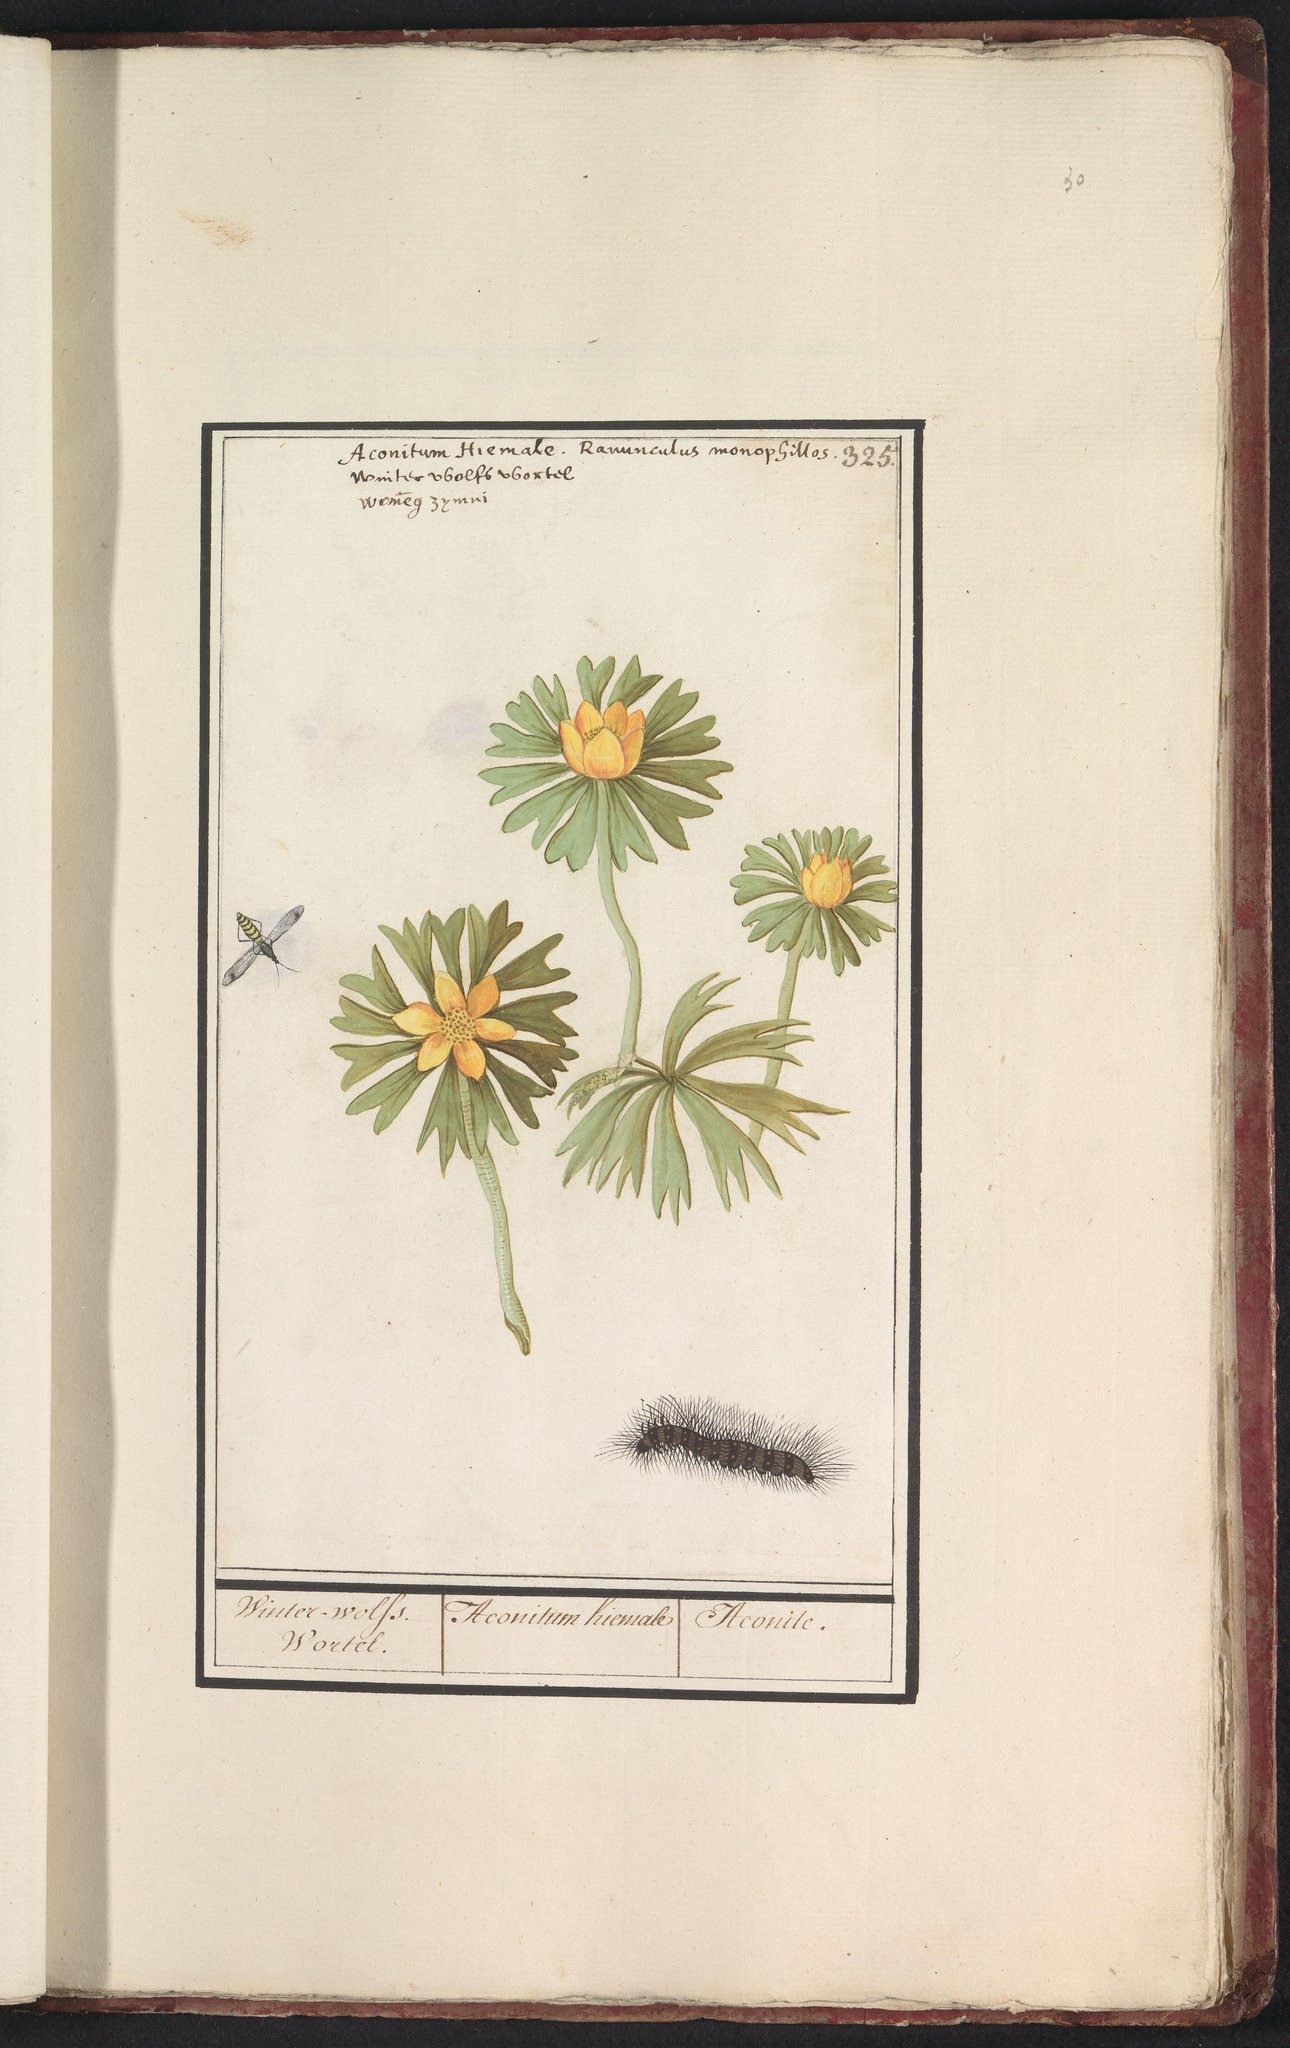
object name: drawing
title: Winterakoniet (Eranthis hyemalis)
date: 1596-1610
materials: chalk, paint, ink, paper, watercolor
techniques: brush, pen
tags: flowers: winter aconite, insects: wasp, insects: caterpillar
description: Winterakoniet. Met een rups en een wespachtig insect. Genummerd rechtsboven: 325. Bovenaan de naam in drie talen. Onderdeel van het vierde album met tekeningen van bloemen en paddestoelen. Elfde van twaalf albums met tekeningen van dieren, vogels en planten bekend rond 1600, gemaakt in opdracht van keizer Rudolf II. Met toelichting in Nederlands, Latijn en Frans.